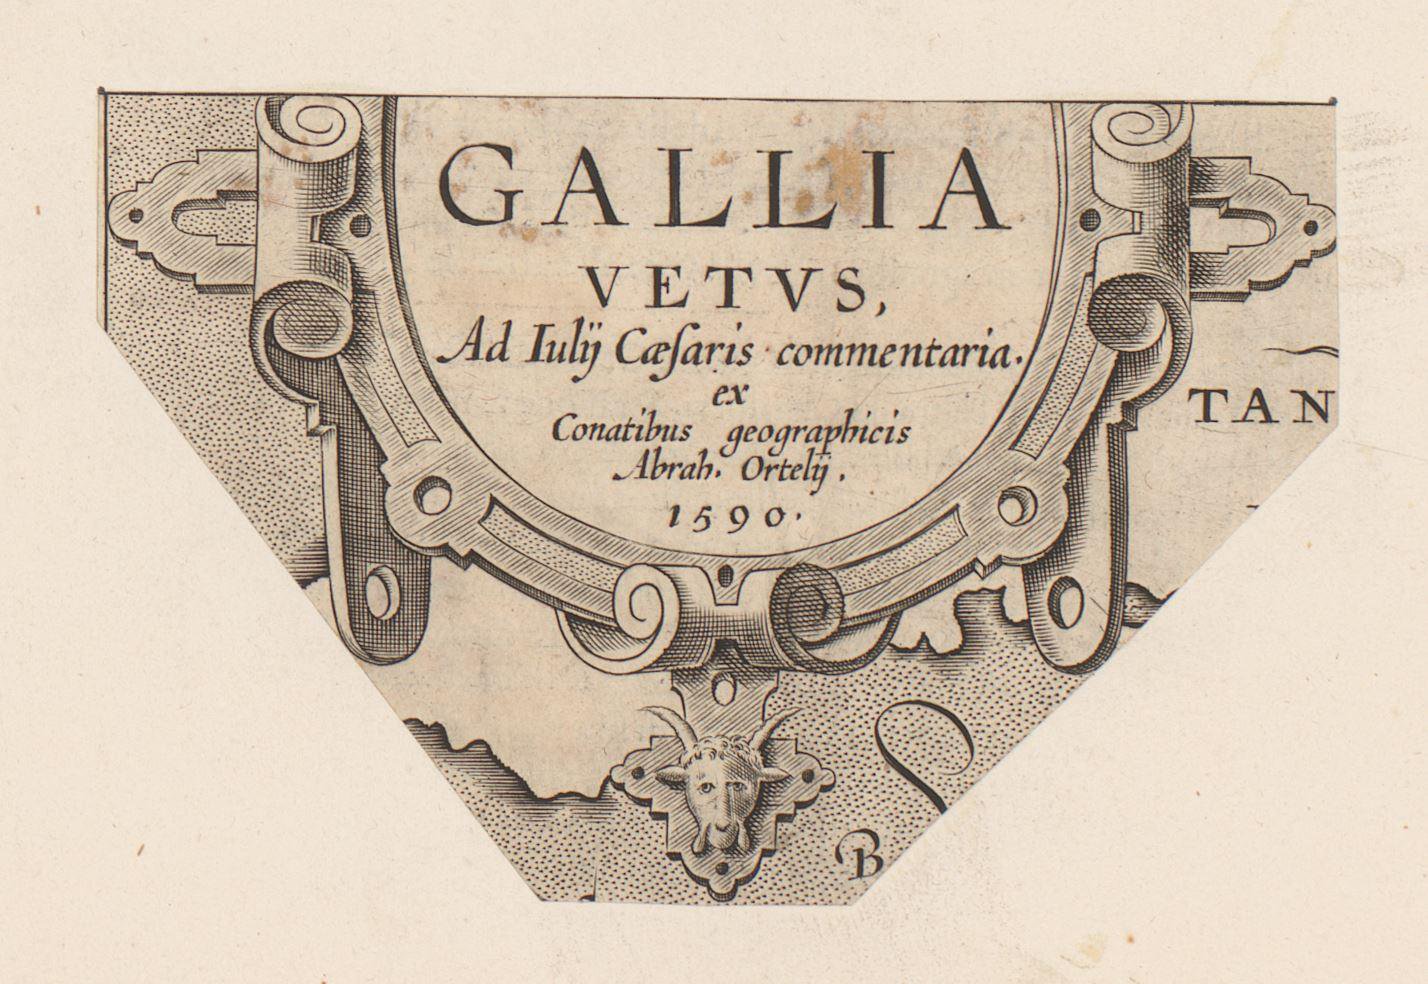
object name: ornament print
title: Hungariae Descriptio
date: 1590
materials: paper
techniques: engraving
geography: antwerp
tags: ornament ~ cartouche, goat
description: De cartouche is gekopieerd naar een prent van een anonieme graveur naar het ontwerp van Hans Vredeman de Vries, onderdeel van een serie van rolwerkcartouches met grotesken uit circa 1555-1560.